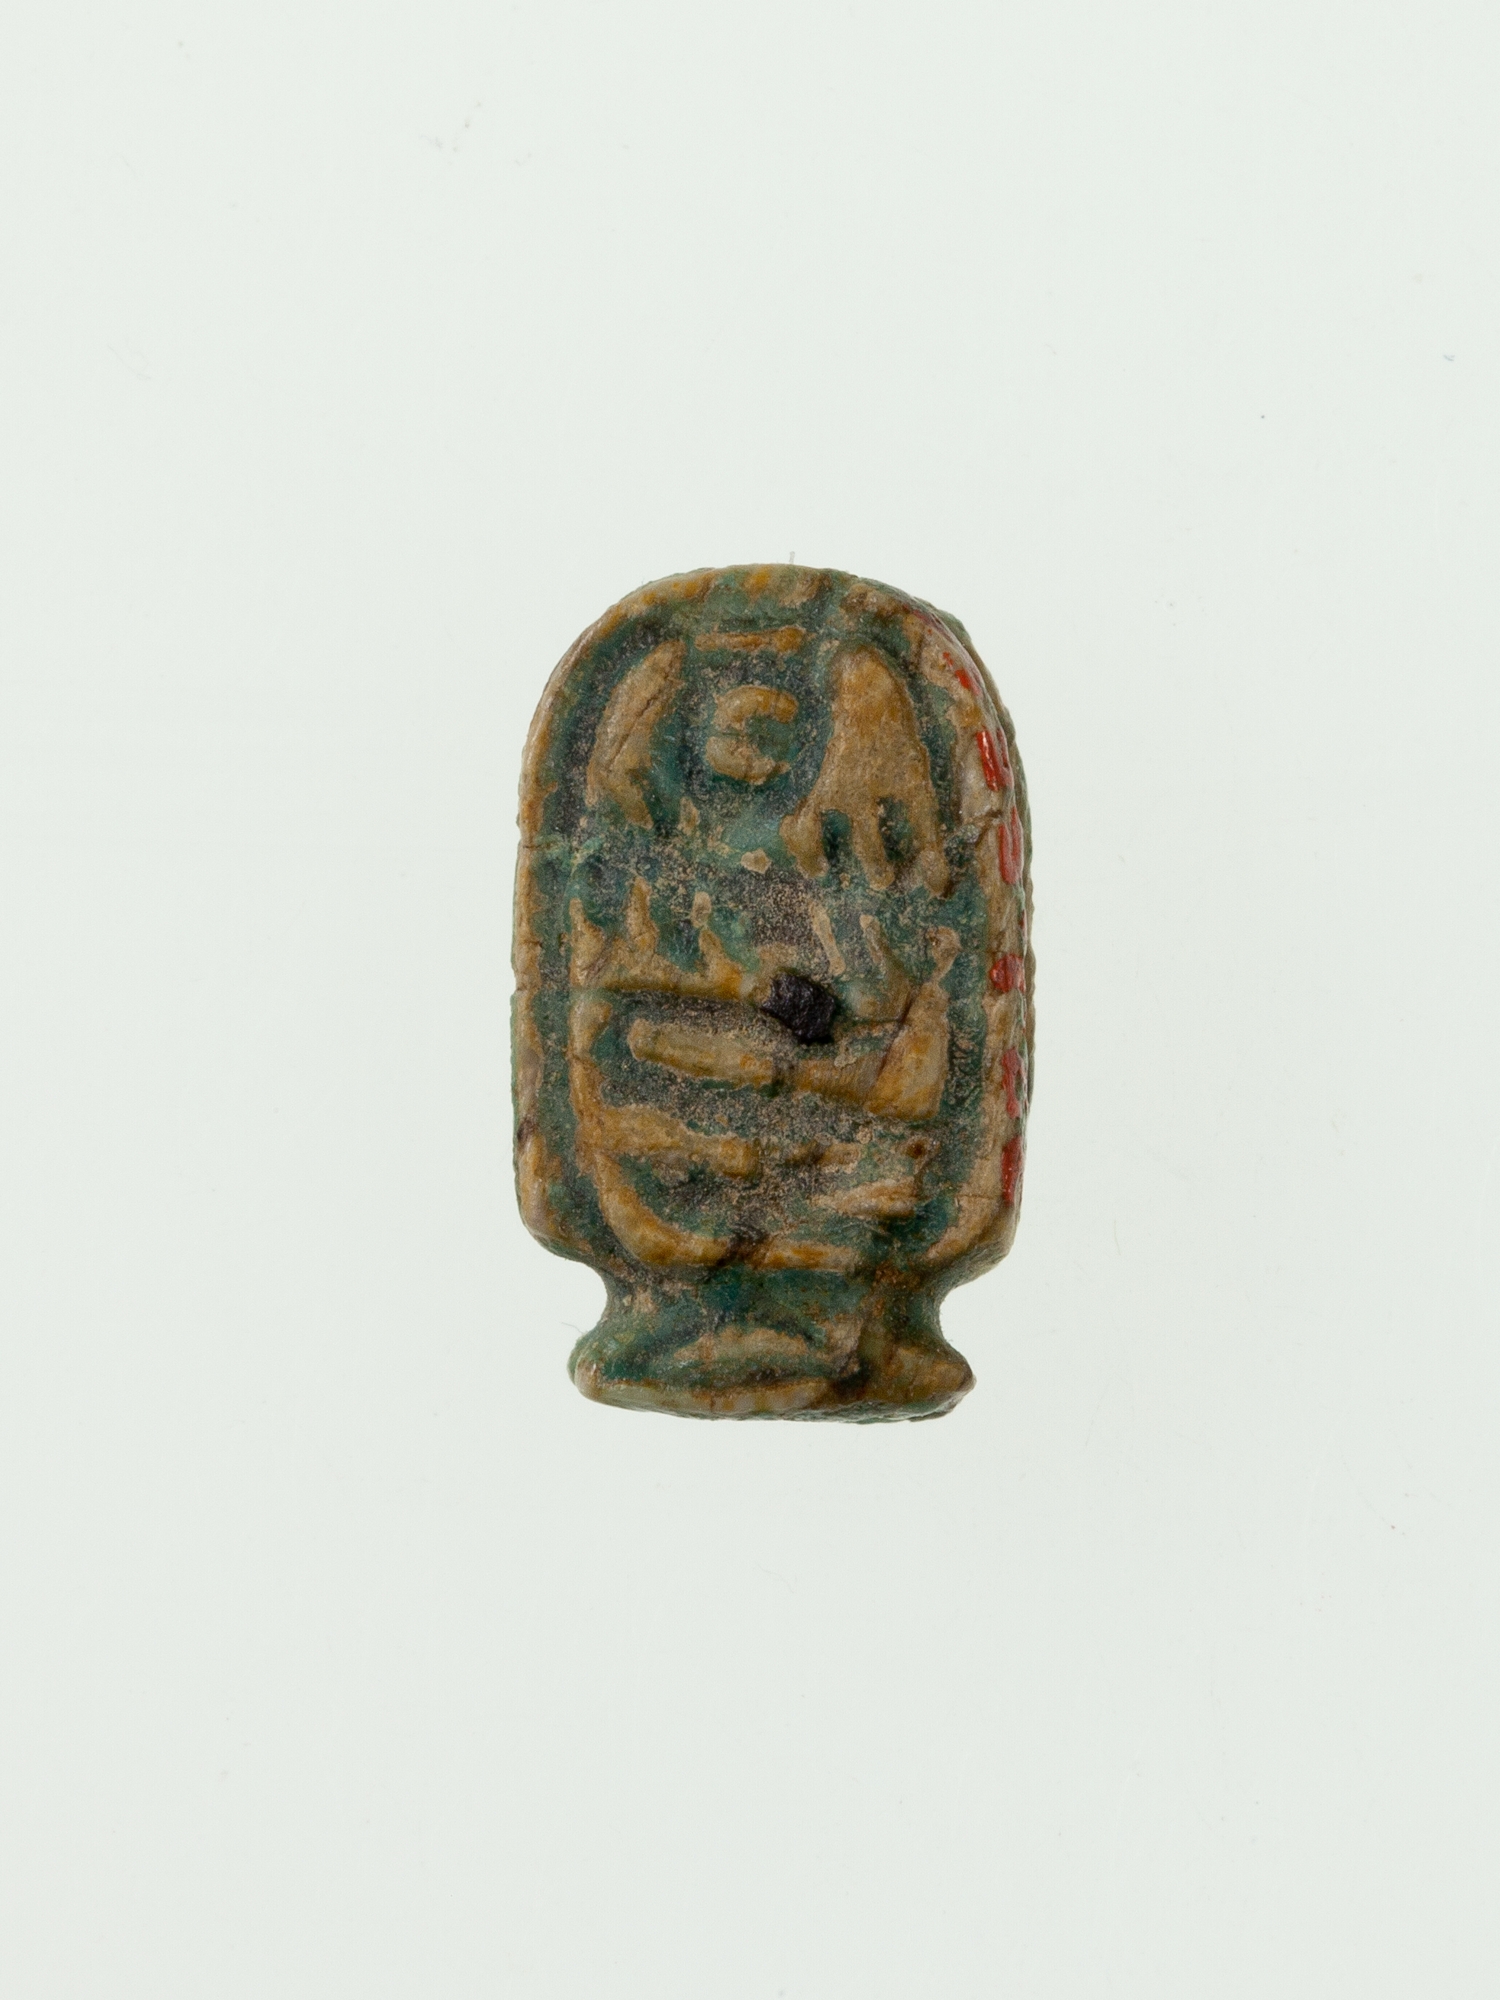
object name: plaque, cartouche, amenemhat iii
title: Cartouche plaque of Amenemhat III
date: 1859-1813 BCE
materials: stone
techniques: glazing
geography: egypt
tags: cartouches